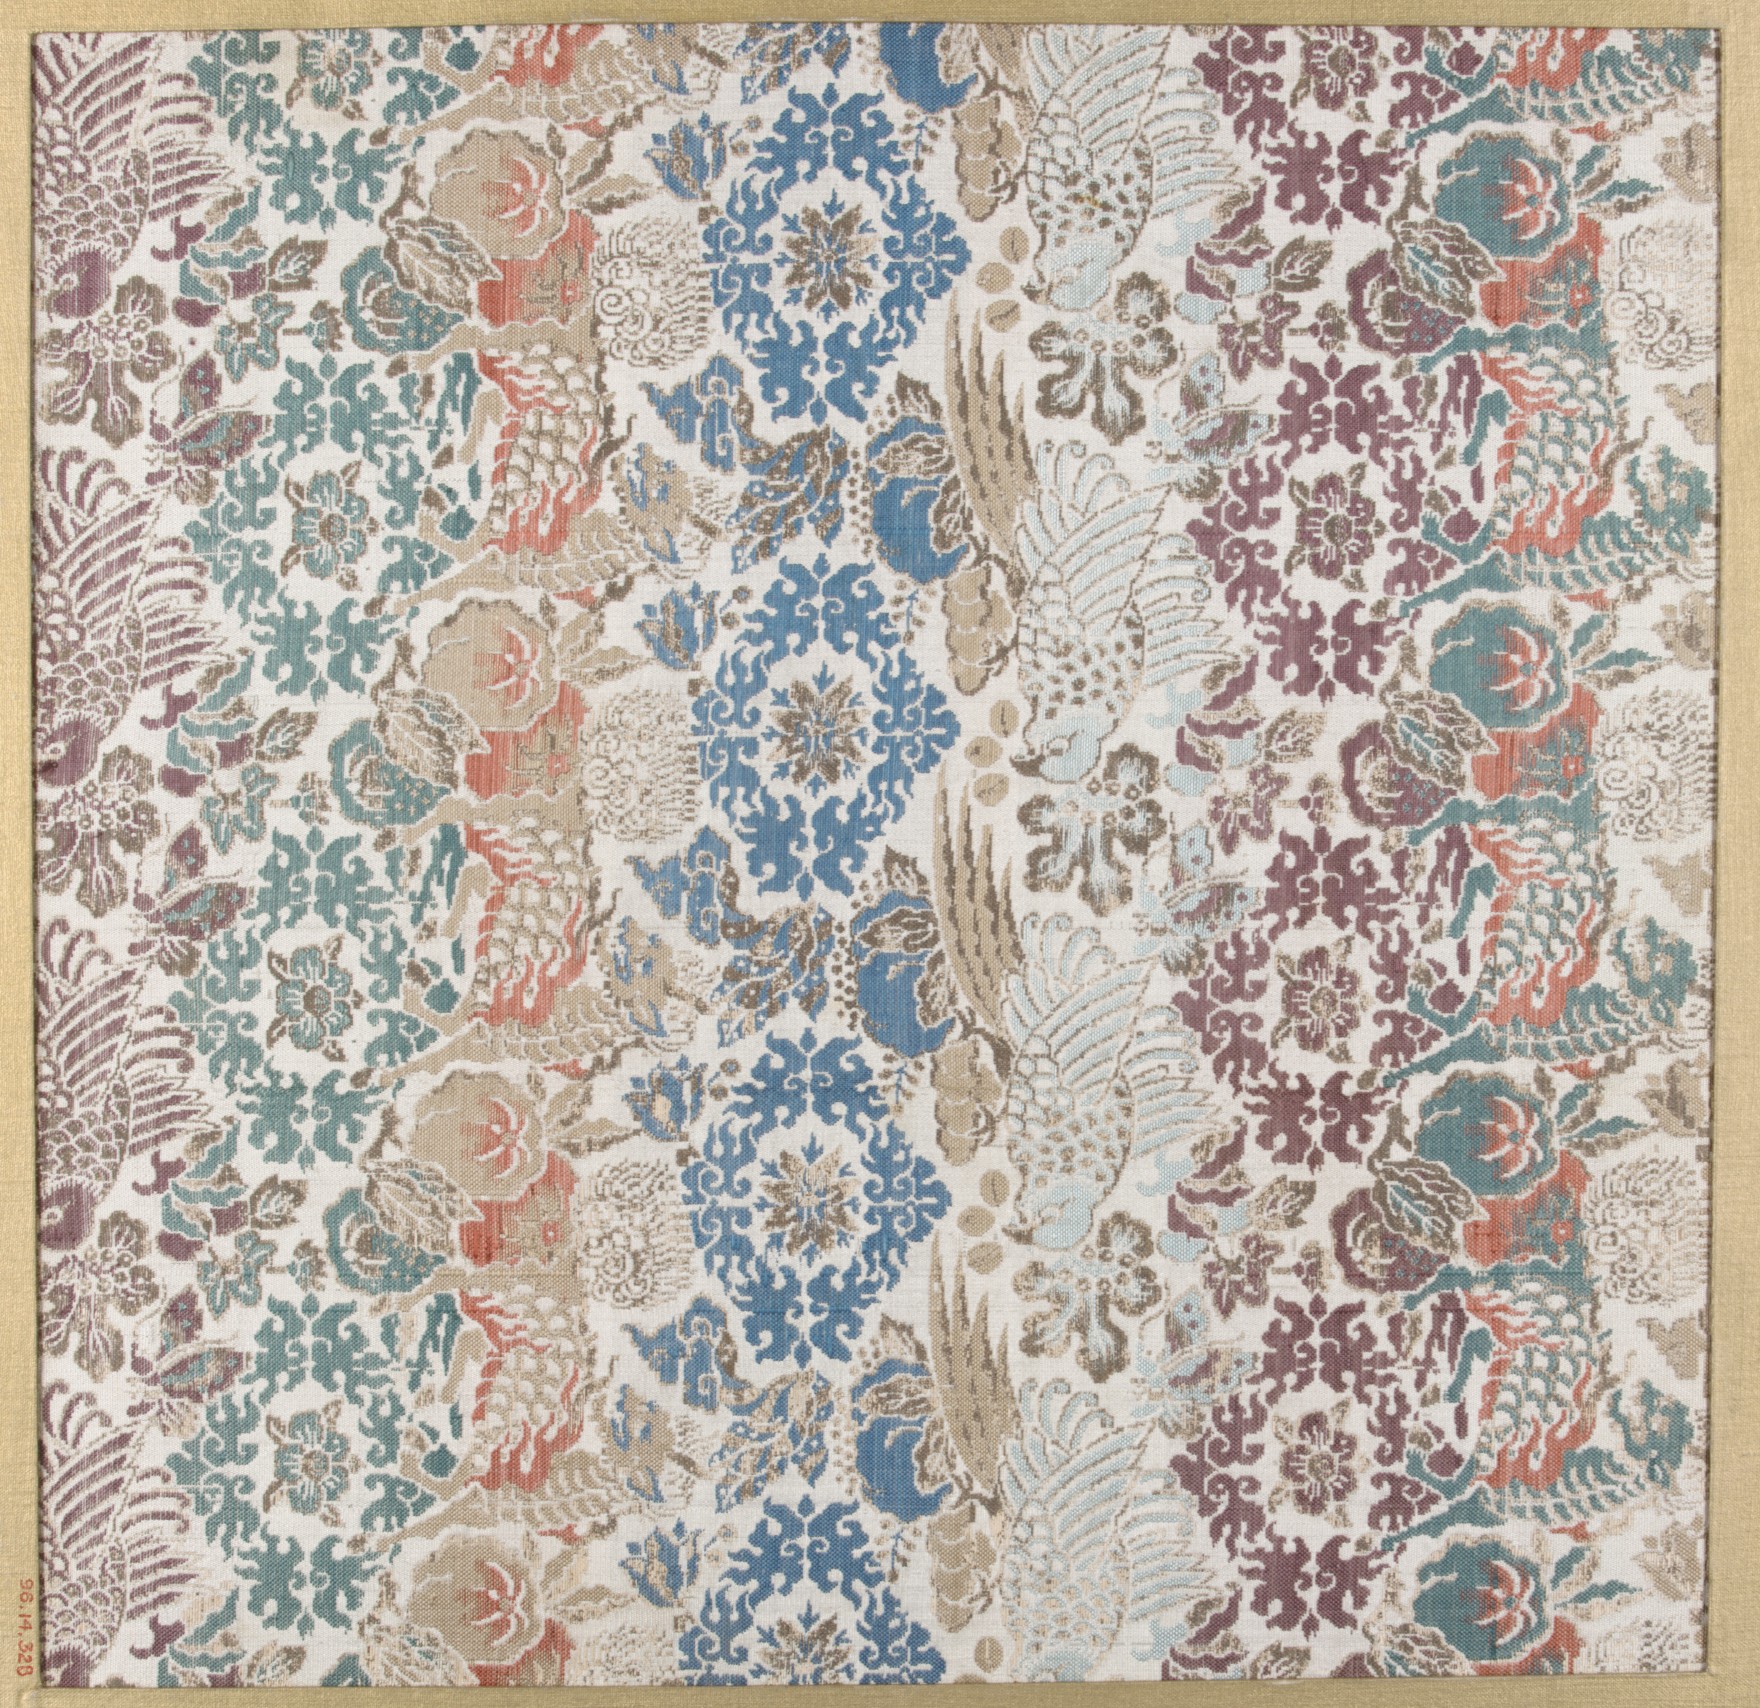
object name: piece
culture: japanese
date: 1701-1900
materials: silk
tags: flowers